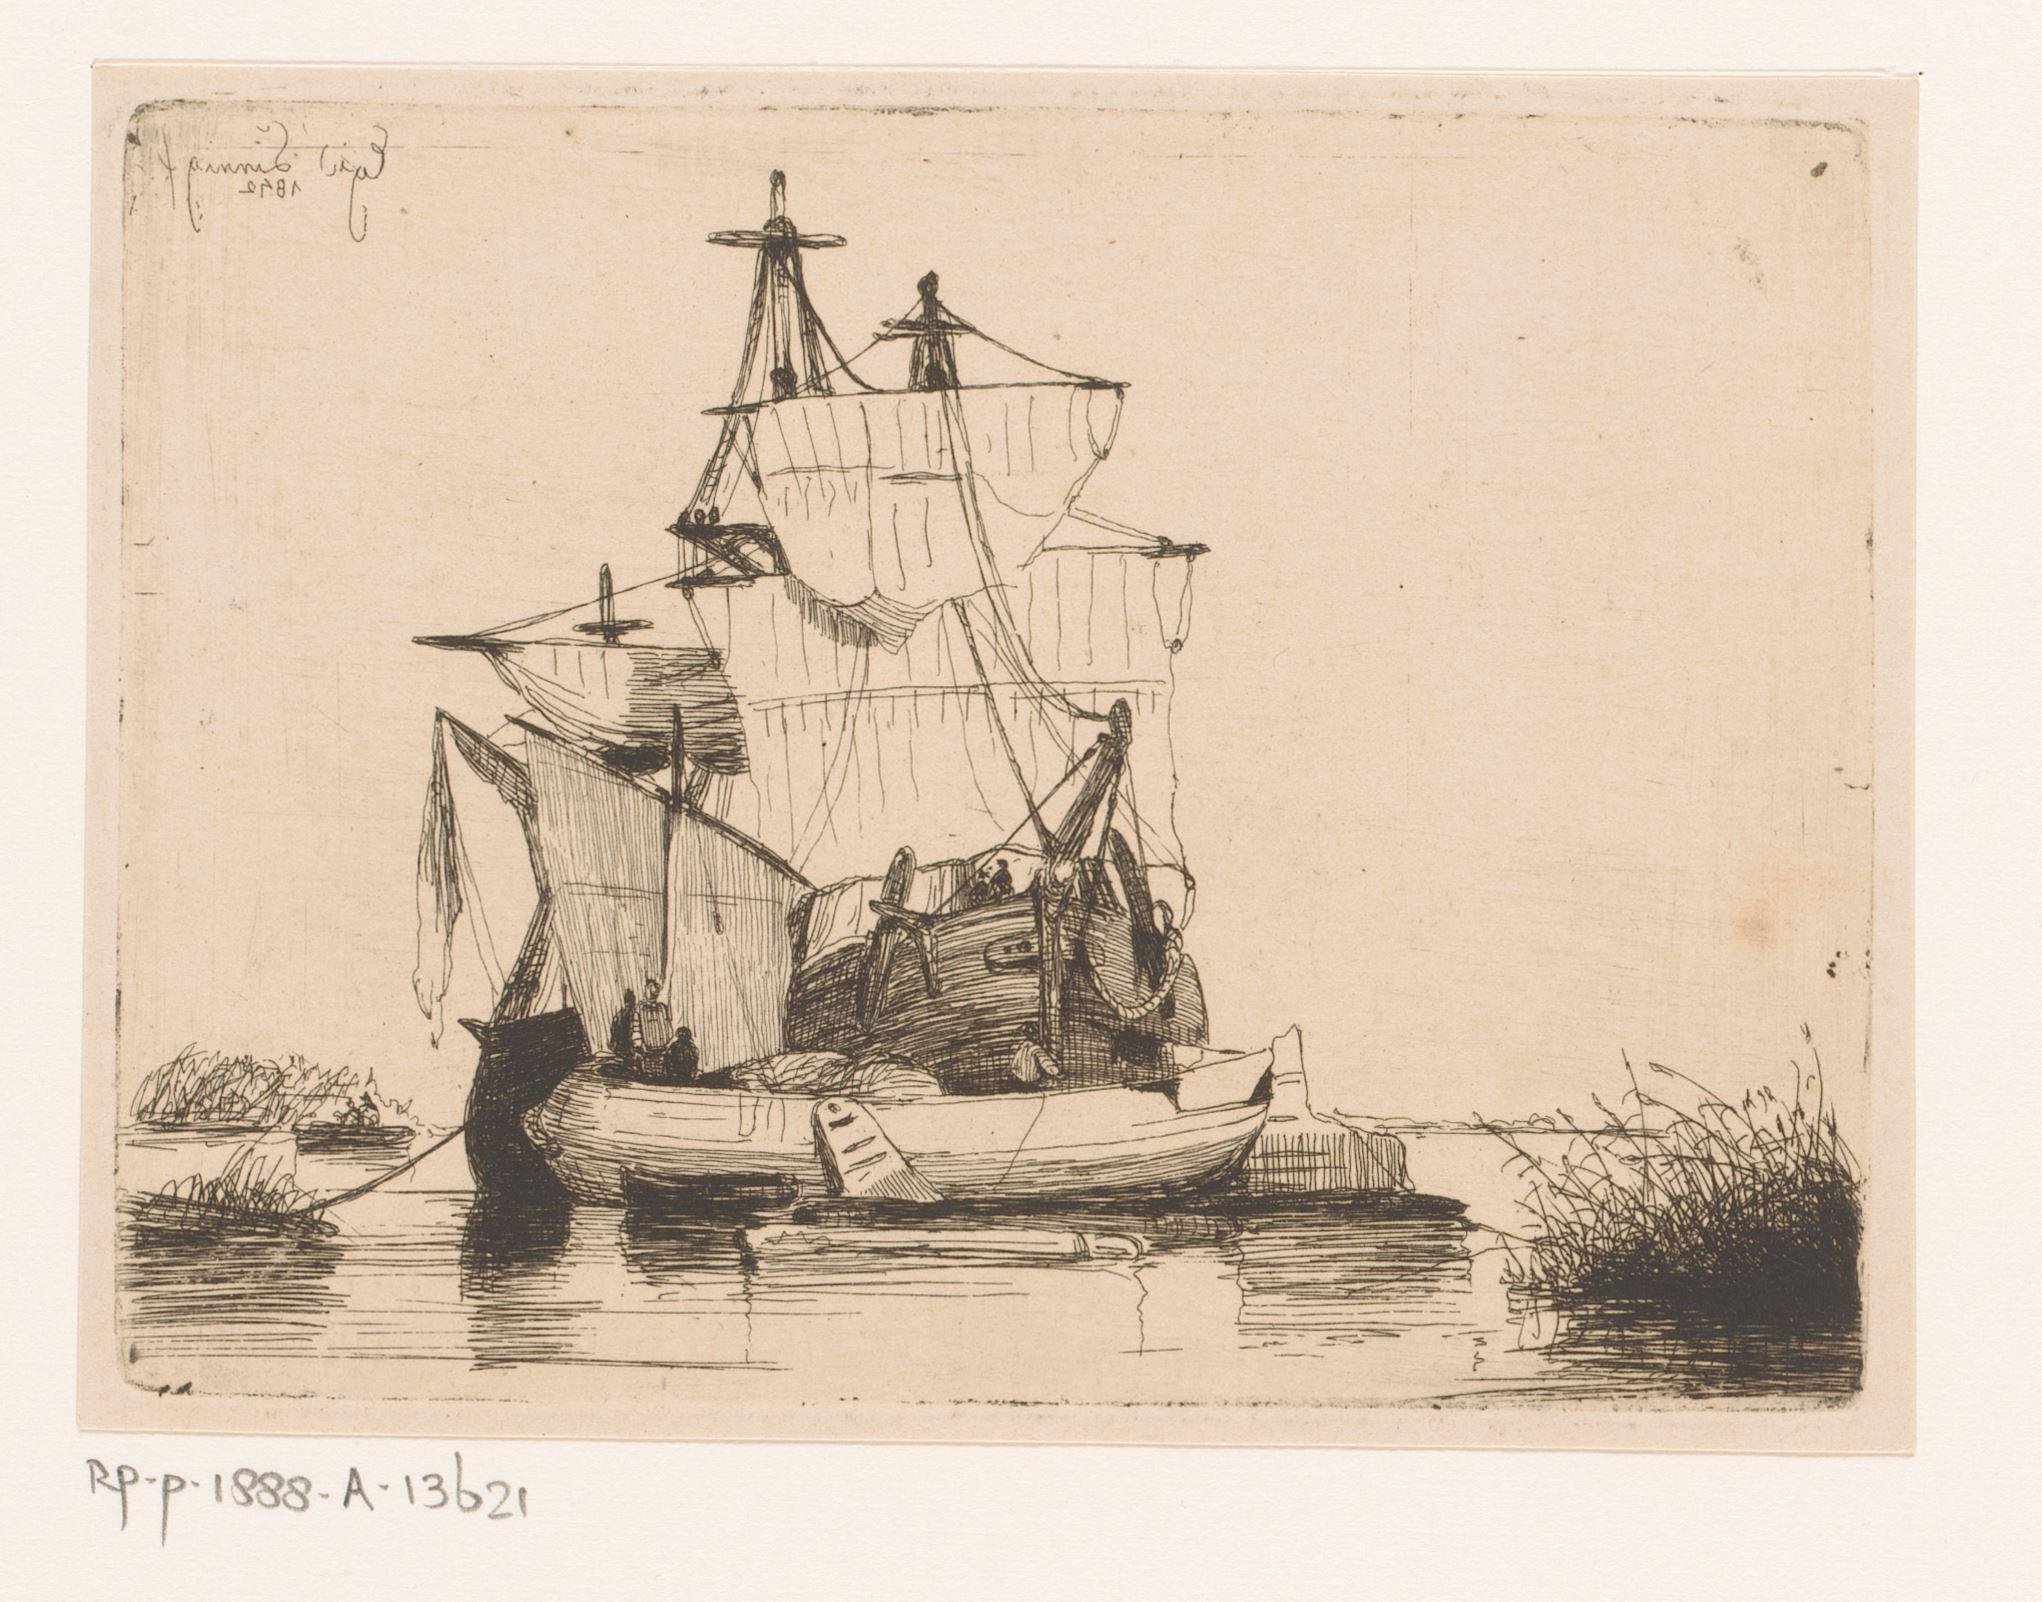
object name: print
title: Driemaster voor anker bij een binnenvaartschip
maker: egidius linnig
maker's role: draughtsman, print maker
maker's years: 1821-1860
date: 1842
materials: paper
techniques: etching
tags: sailing-ship, sailing-boat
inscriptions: collector's mark: Lugt 2228